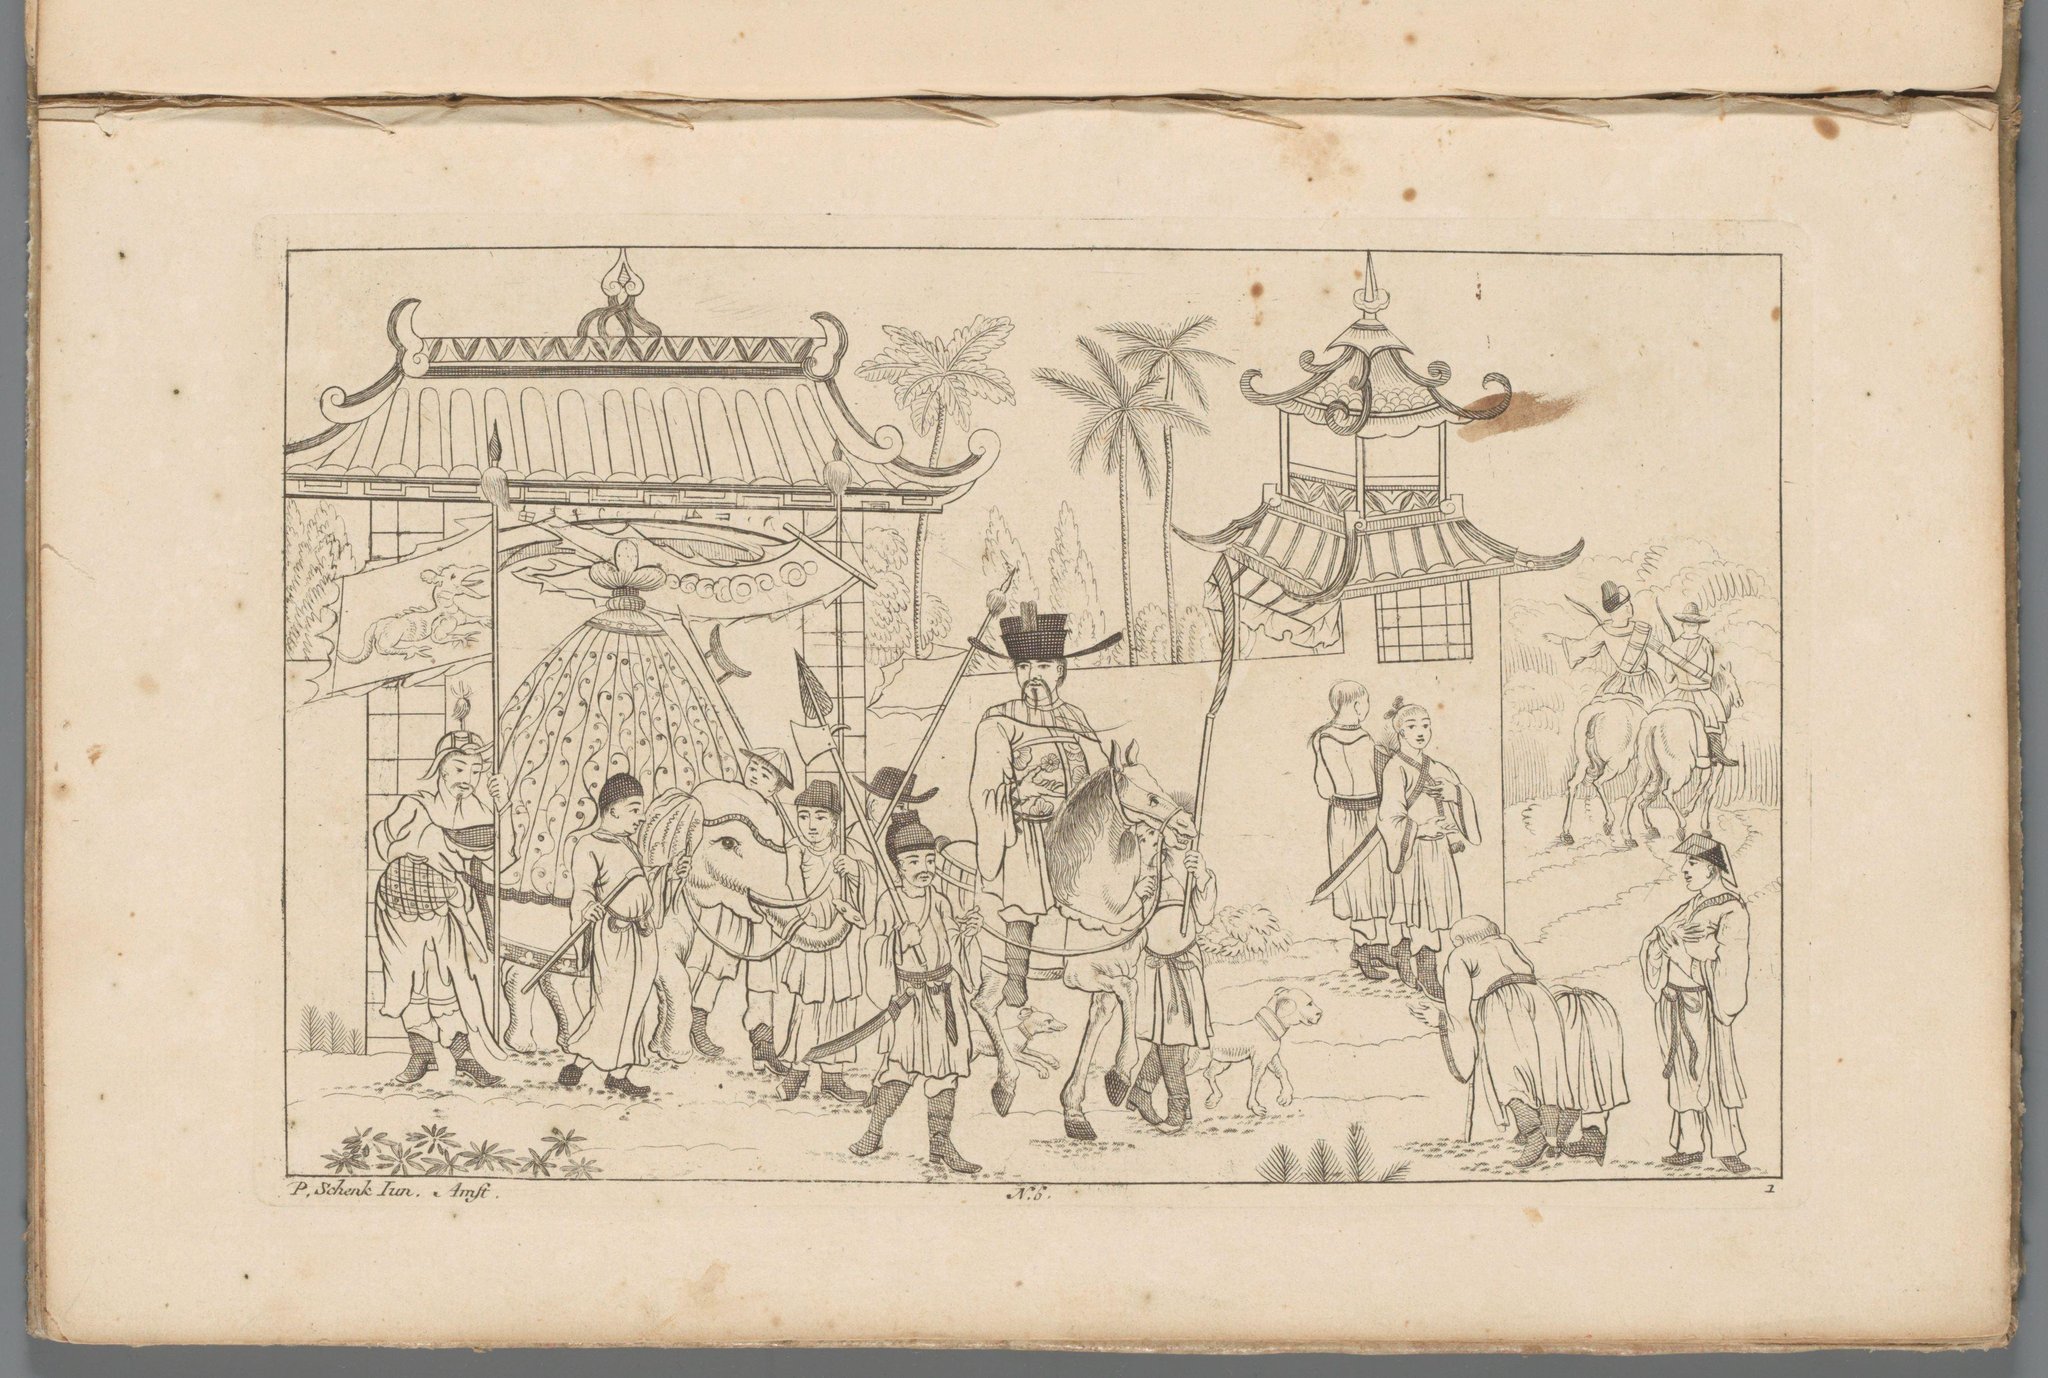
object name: ornament print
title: Nieuwe geinventeerde Sineesen, met groote moeyte geteekent en in 't Ligt gegeven, door P: Schenk Jun (...), derde deel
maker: pieter schenk (ii)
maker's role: draughtsman, print maker, publisher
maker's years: 1693-1775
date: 1727-1775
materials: paper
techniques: etching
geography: amsterdam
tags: chinese, triumphal entry and public reception, pageant, 'entrée solennelle', 'joyeuse entrée', trunked animals: elephant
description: Een Chinese vorst of heer gaat te paard in optocht door een poort. Achter hem wordt een olifant meegevoerd. Rechts buigen mensen voor de man te paard. Midden onder genummerd: 6. Prent maakt deel uit van een album.